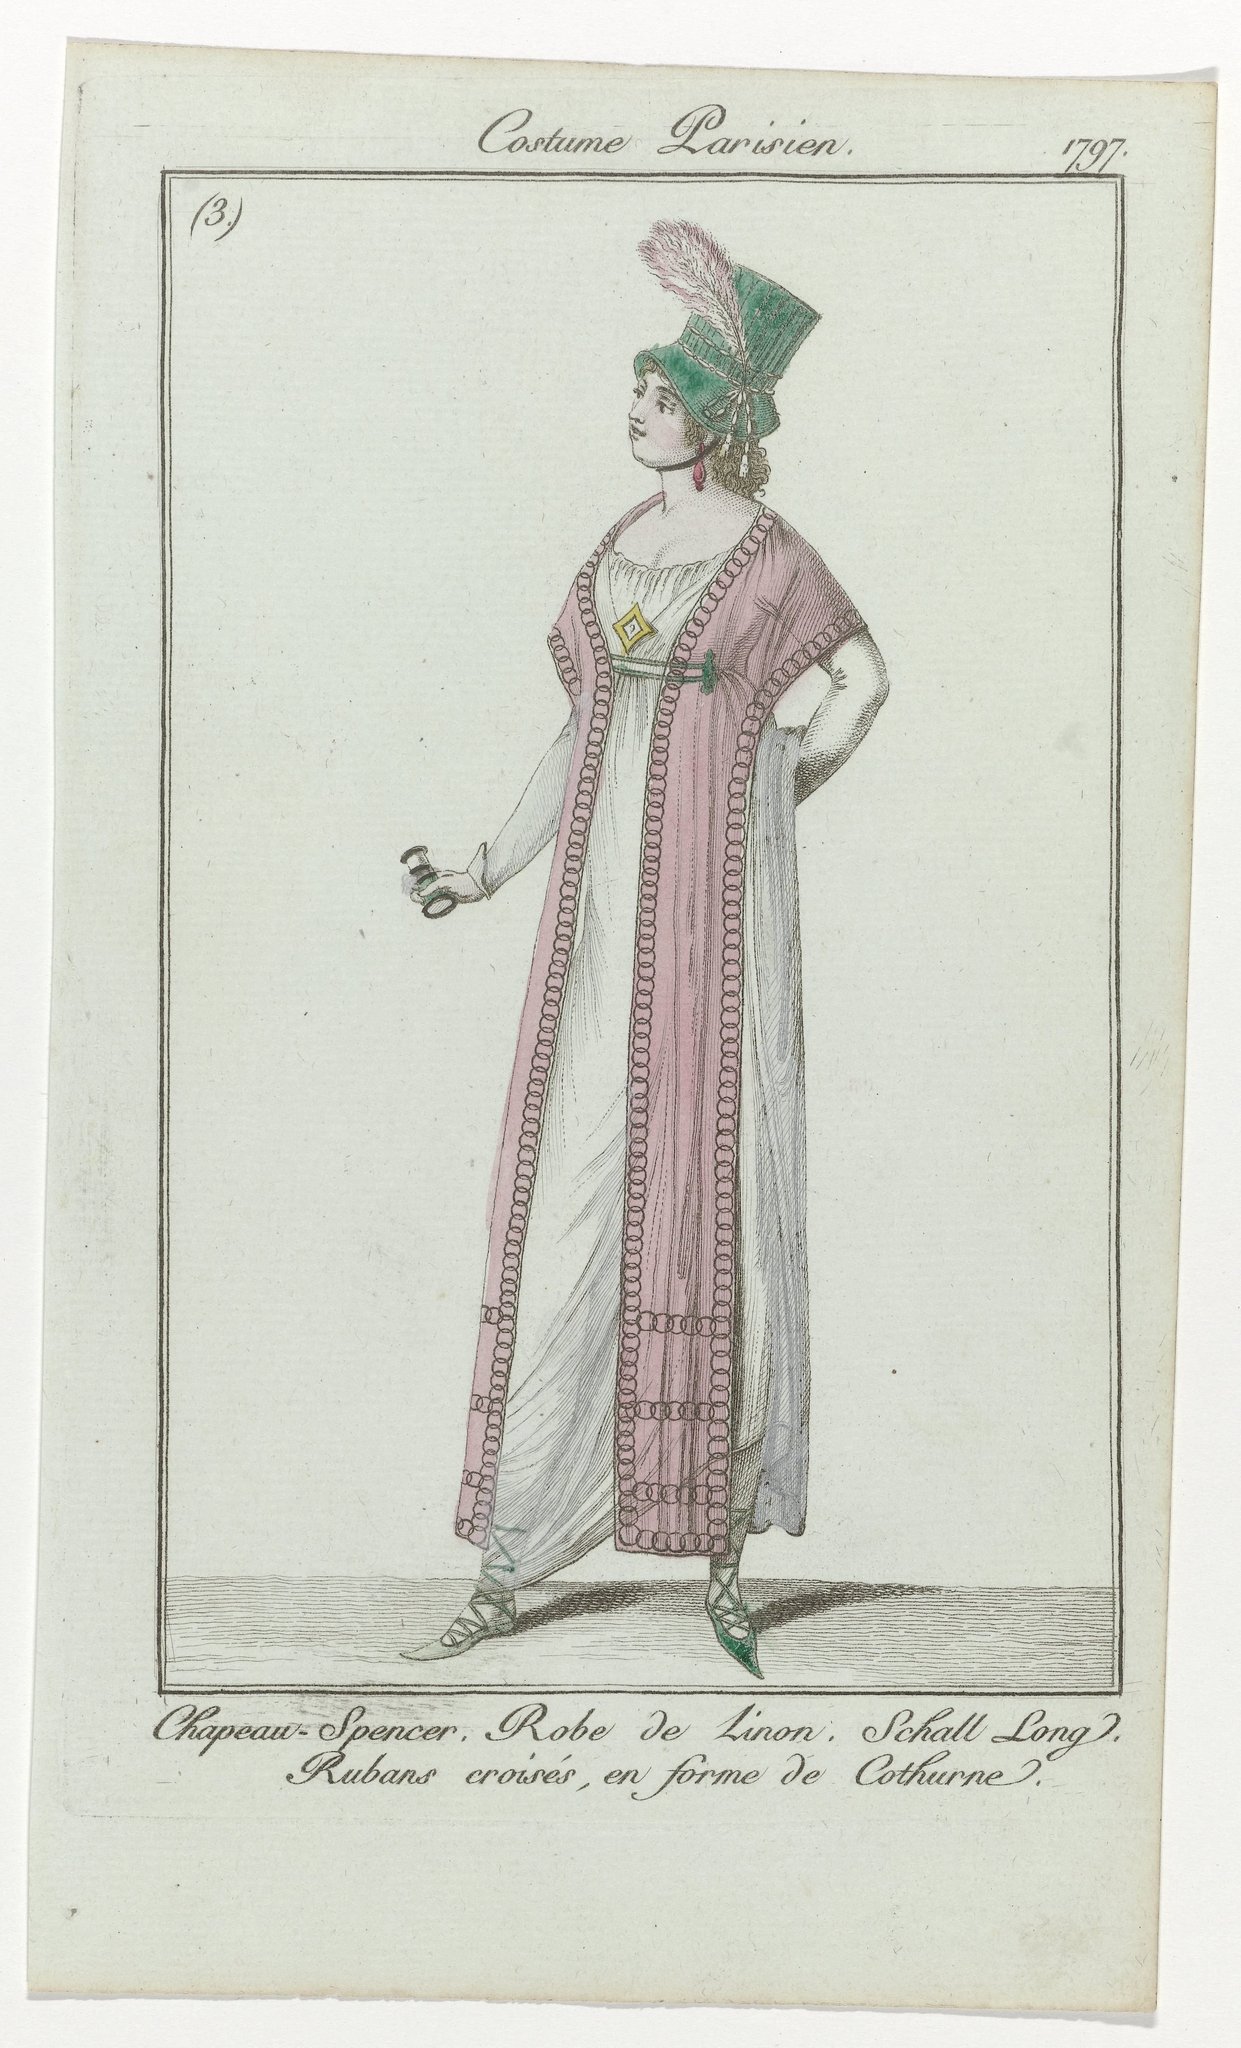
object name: fashion print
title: Journal des Dames et des Modes, Costume Parisien, juillet 1797, (3): Chapeau-Spencer. Robe de linon (...)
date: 1797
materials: paper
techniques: engraving, hand coloring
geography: paris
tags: ear-rings (+ women's clothes), clothing for the upper part of the body (shawl) (+ women's clothes), fashion plates, head-gear: hat (+ women's clothes), dress, gown (+ women's clothes), shoes, sandals, necklace (+ women's clothes), binoculars, spy-glass, etc.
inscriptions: title: ‘Costume Parisien.’, caption: ‘Chapeau-Spencer. Robe de linon. Schall Long. Rubans croisés, en forme de Cothurne.’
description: Japon van linnen met lange mouwen. Lange sjaal. 'Chapeau-spencer' op het hoofd. platte schoenen met gekruiste linten, die 'cothurnes' vormen. De prent maakt deel uit van het modetijdschrift Journal des Dames et des Modes, uitgegeven door Sellèque, Parijs, 1797-1839. Deze prent werd eerder uitgegeven in het 'Journal des Modes et Nouveautés' als nummer 3, met als onderschrift 'Costumes'.